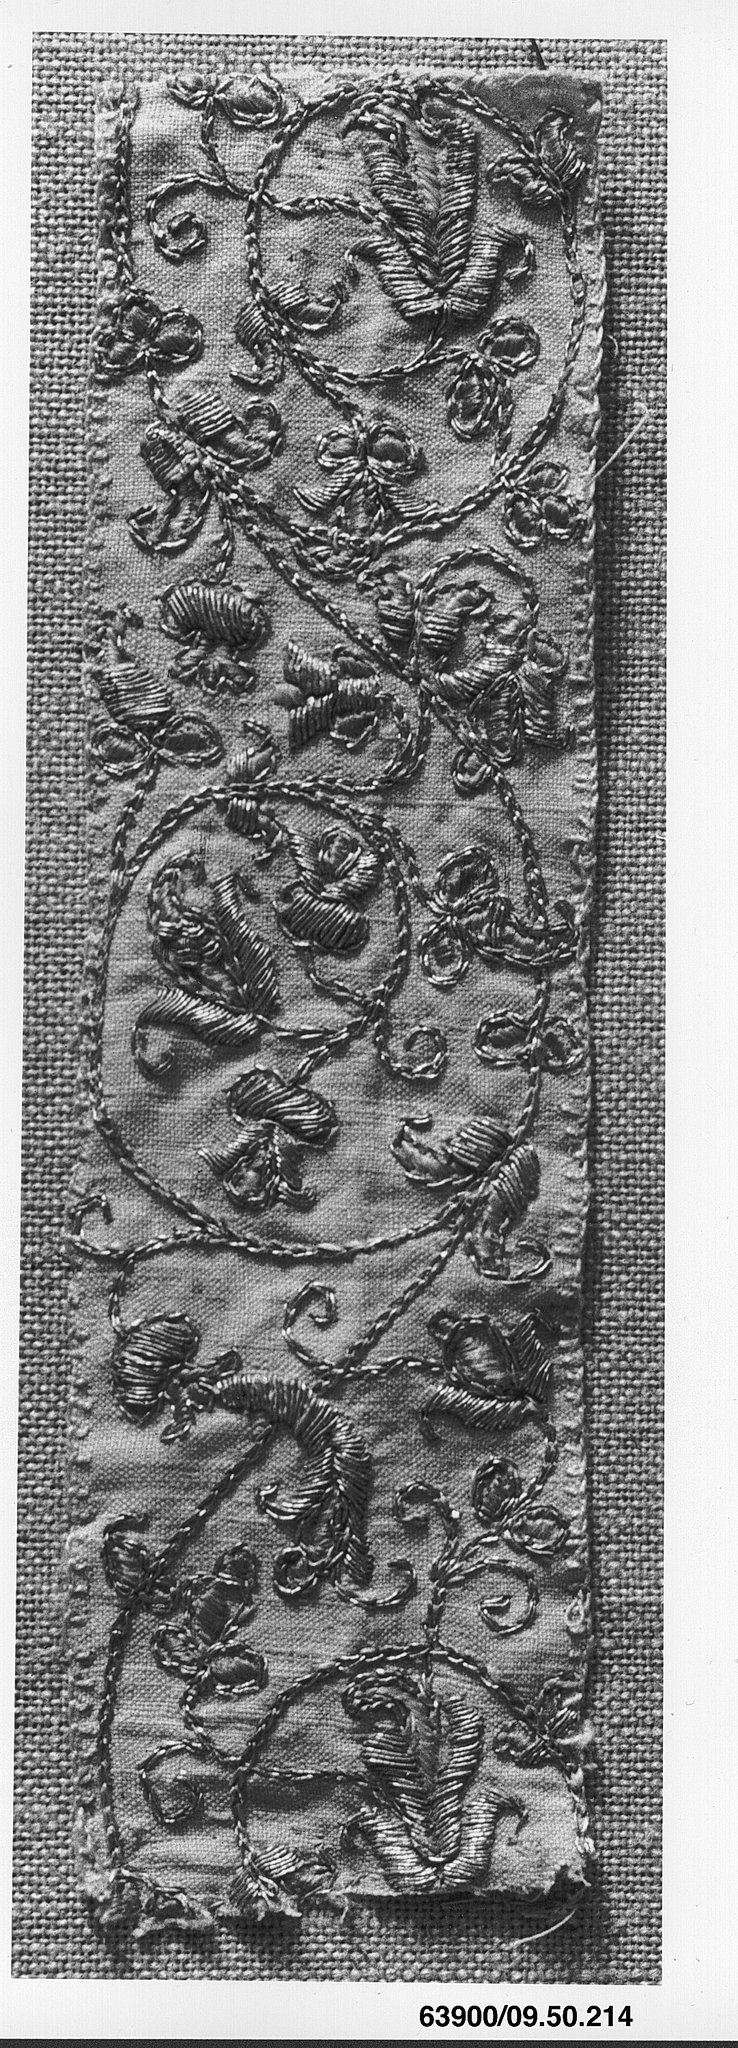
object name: fragment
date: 1601-1700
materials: linen, metal thread